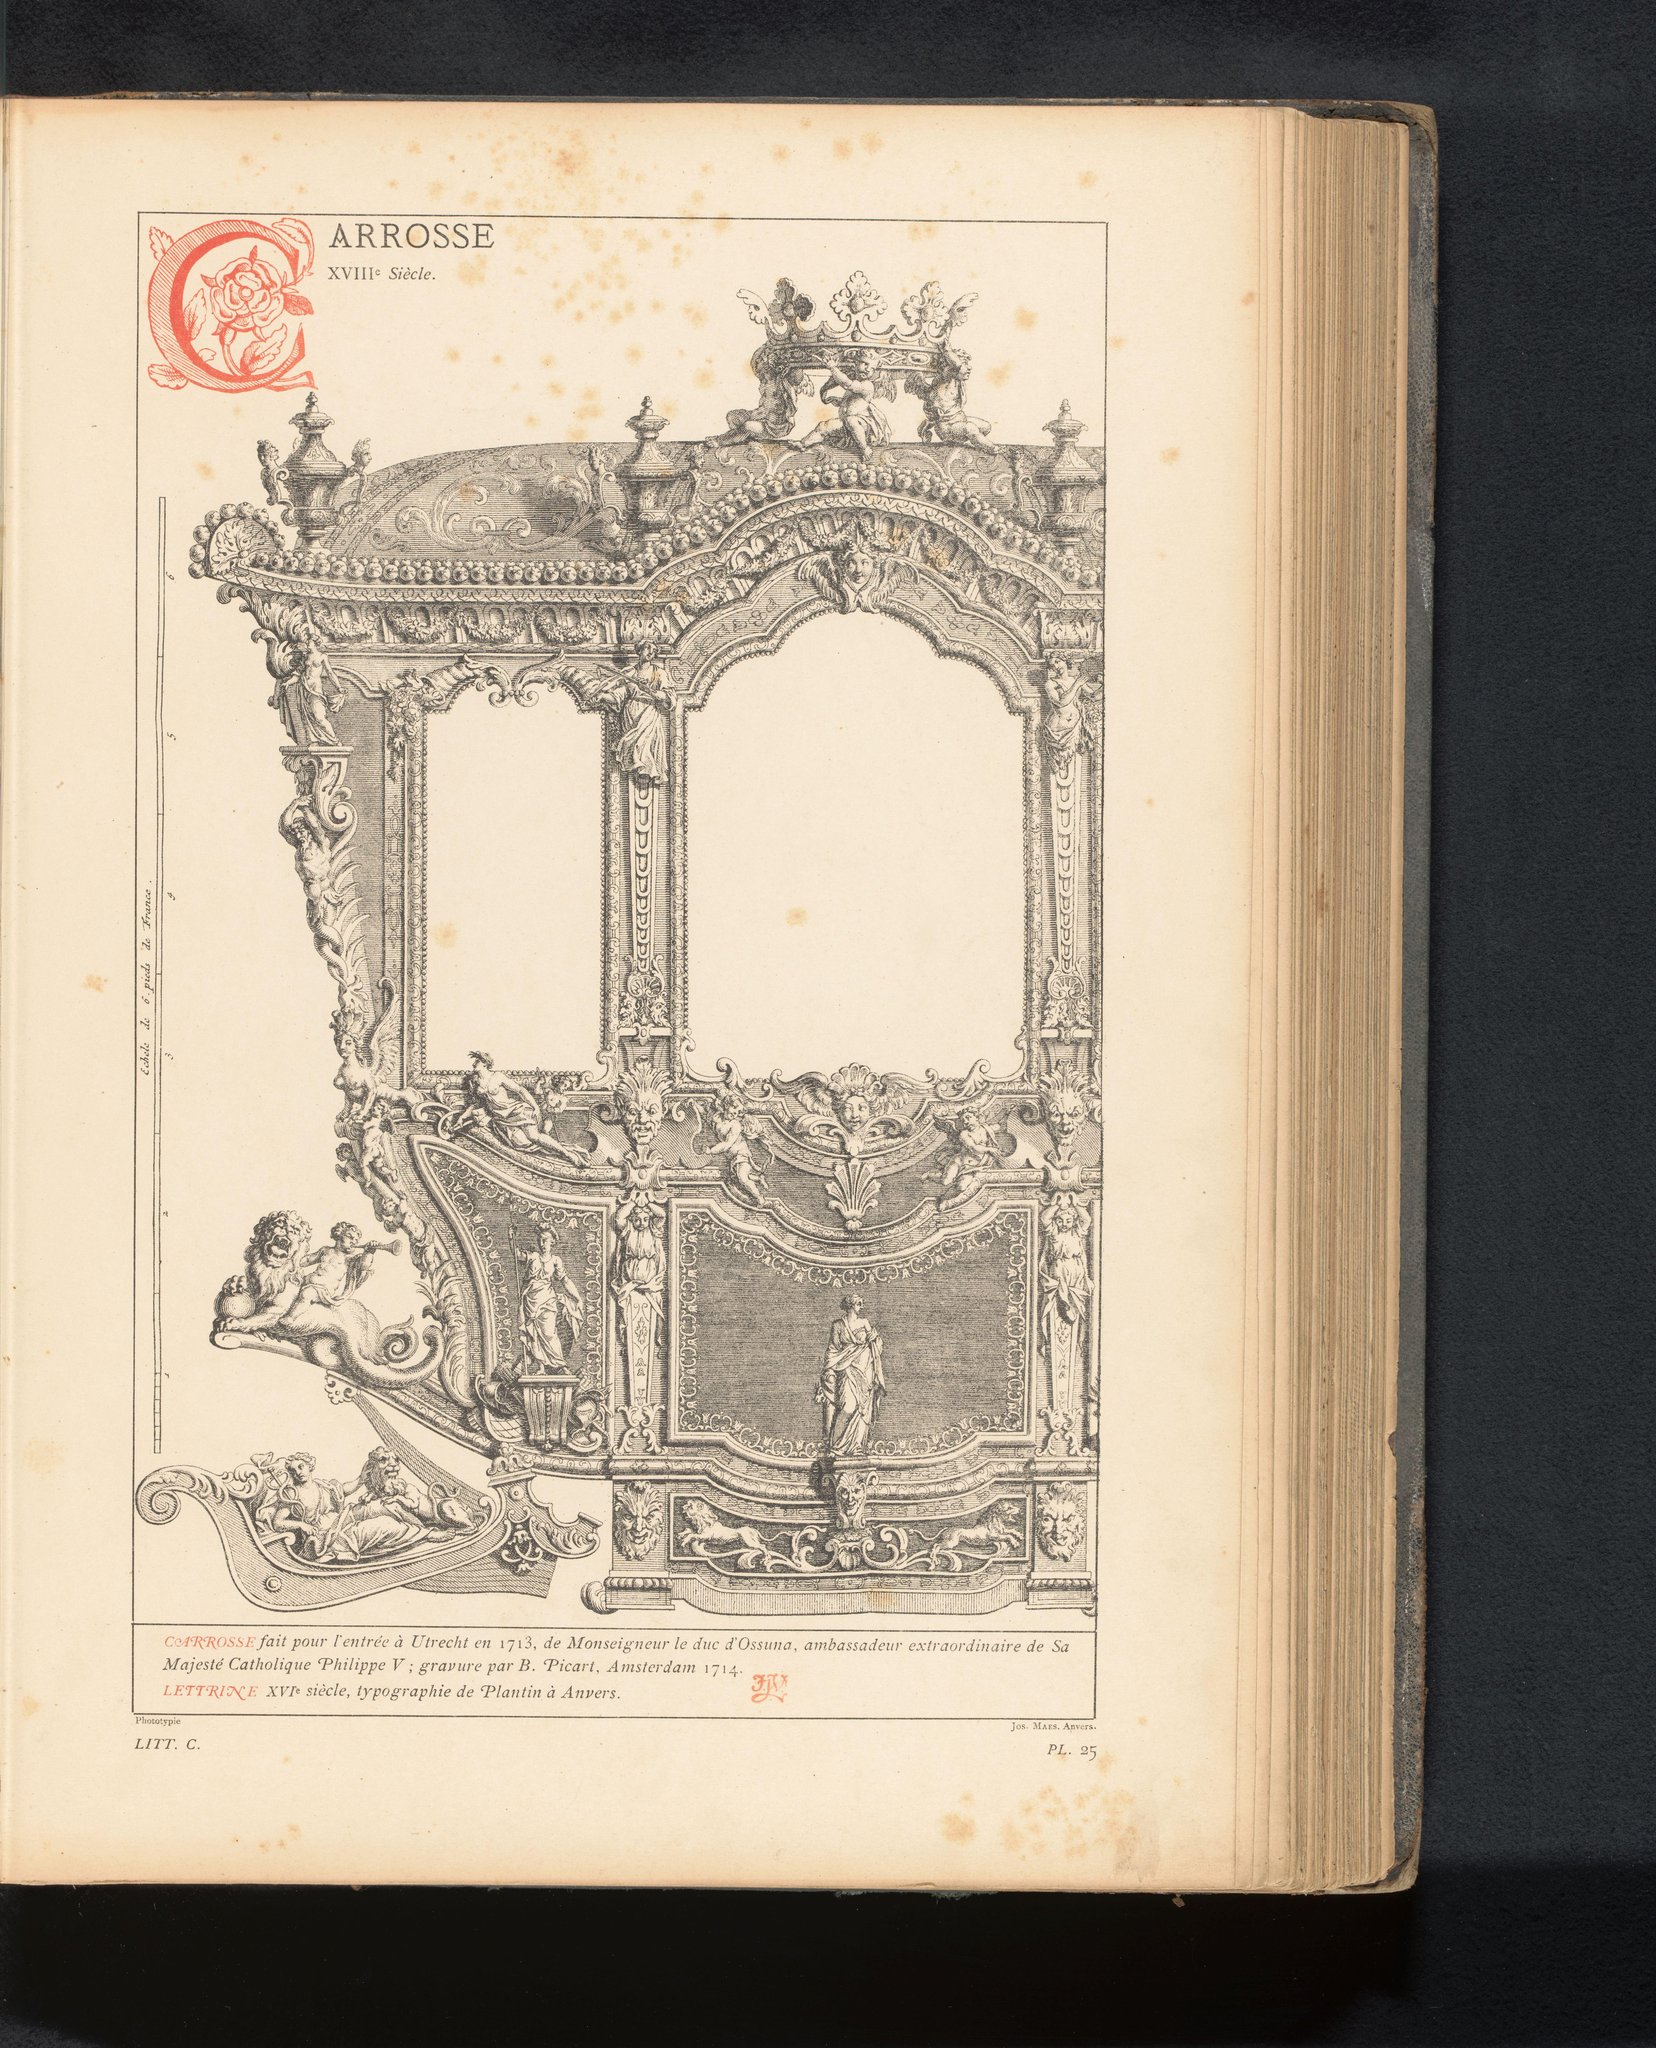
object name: photomechanical print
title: Carrosse, XVIIIe Siècle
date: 1875-1880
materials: paper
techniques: photolithography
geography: antwerp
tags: four-wheeled, animal-drawn vehicle, e.g.: cab, carriage, coach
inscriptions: inscription: ‘Carosse fait pour (...)’, inscription: ‘LITT: C. - PL. 25’, monogram: ‘JJvY’